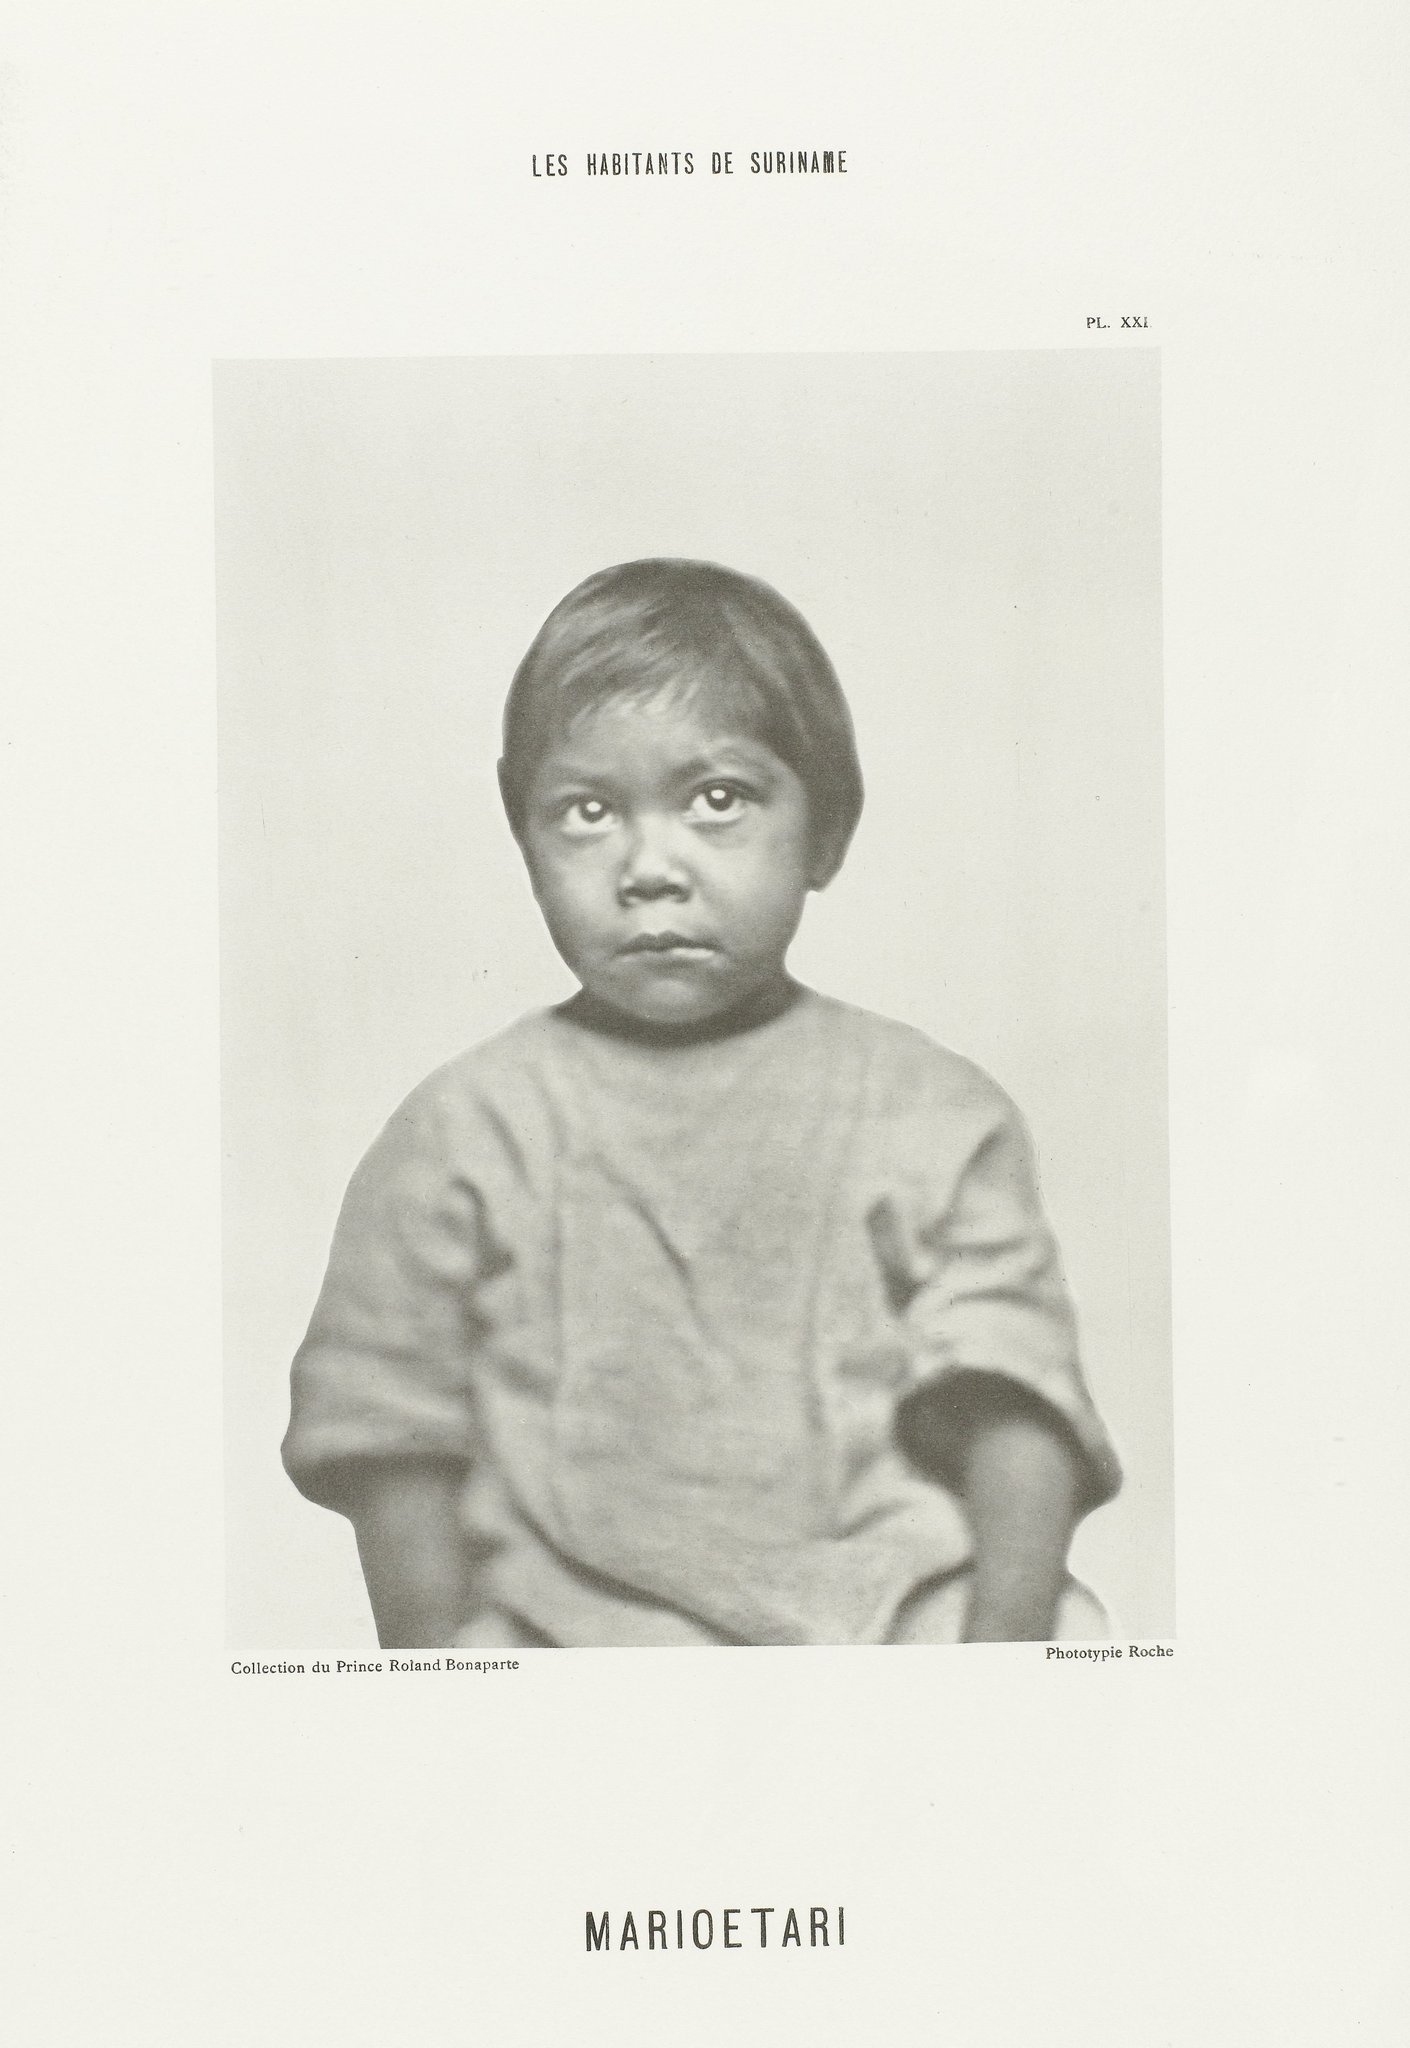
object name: page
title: Portret van Marioetari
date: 1883-1884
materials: paper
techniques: photograph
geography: amsterdam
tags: historical persons, indigenous peoples of south america, tot, toddler ~ the ages of man, amsterdam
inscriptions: inscription: ‘Collection du Prince Roland Bonaparte/ Phototypie Roche’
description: Portret van Marioetari, een Caraïb uit Suriname, gefotografeerd op de Internationale Koloniale en Uitvoerhandel Tentoonstelling, Amsterdam 1883.